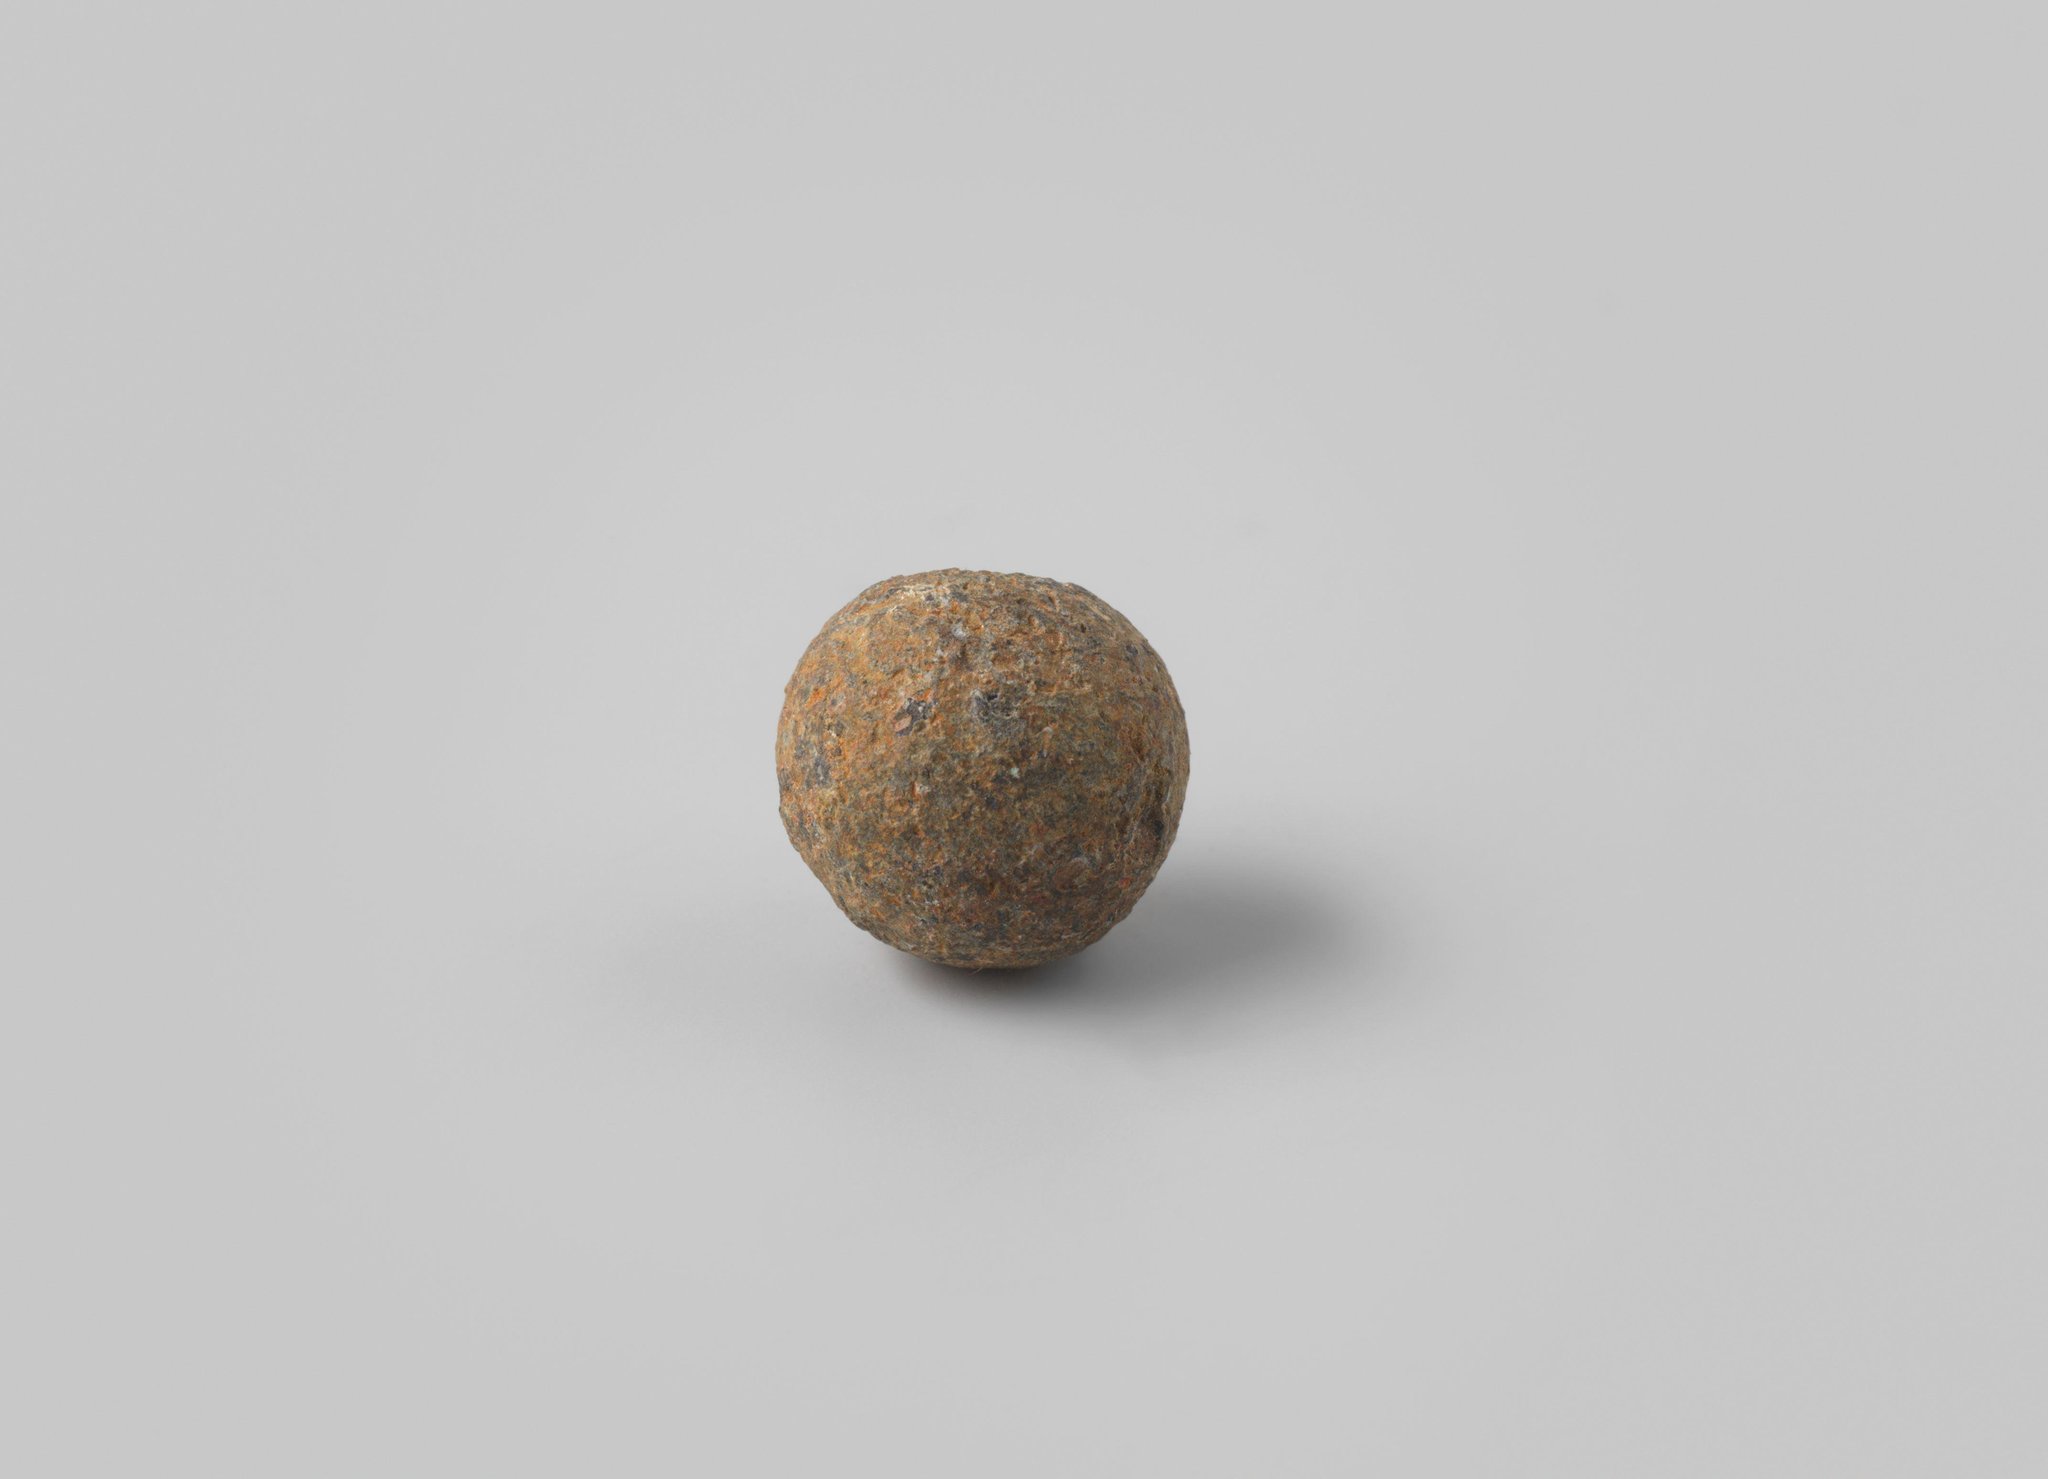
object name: bullet ammunition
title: Pistoolkogel uit het wrak van de Oost-Indiëvaarder Hollandia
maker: Anonymous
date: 1700-1743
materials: lead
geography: netherlands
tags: verenigde oostindische compagnie, hollandia (schip), annet